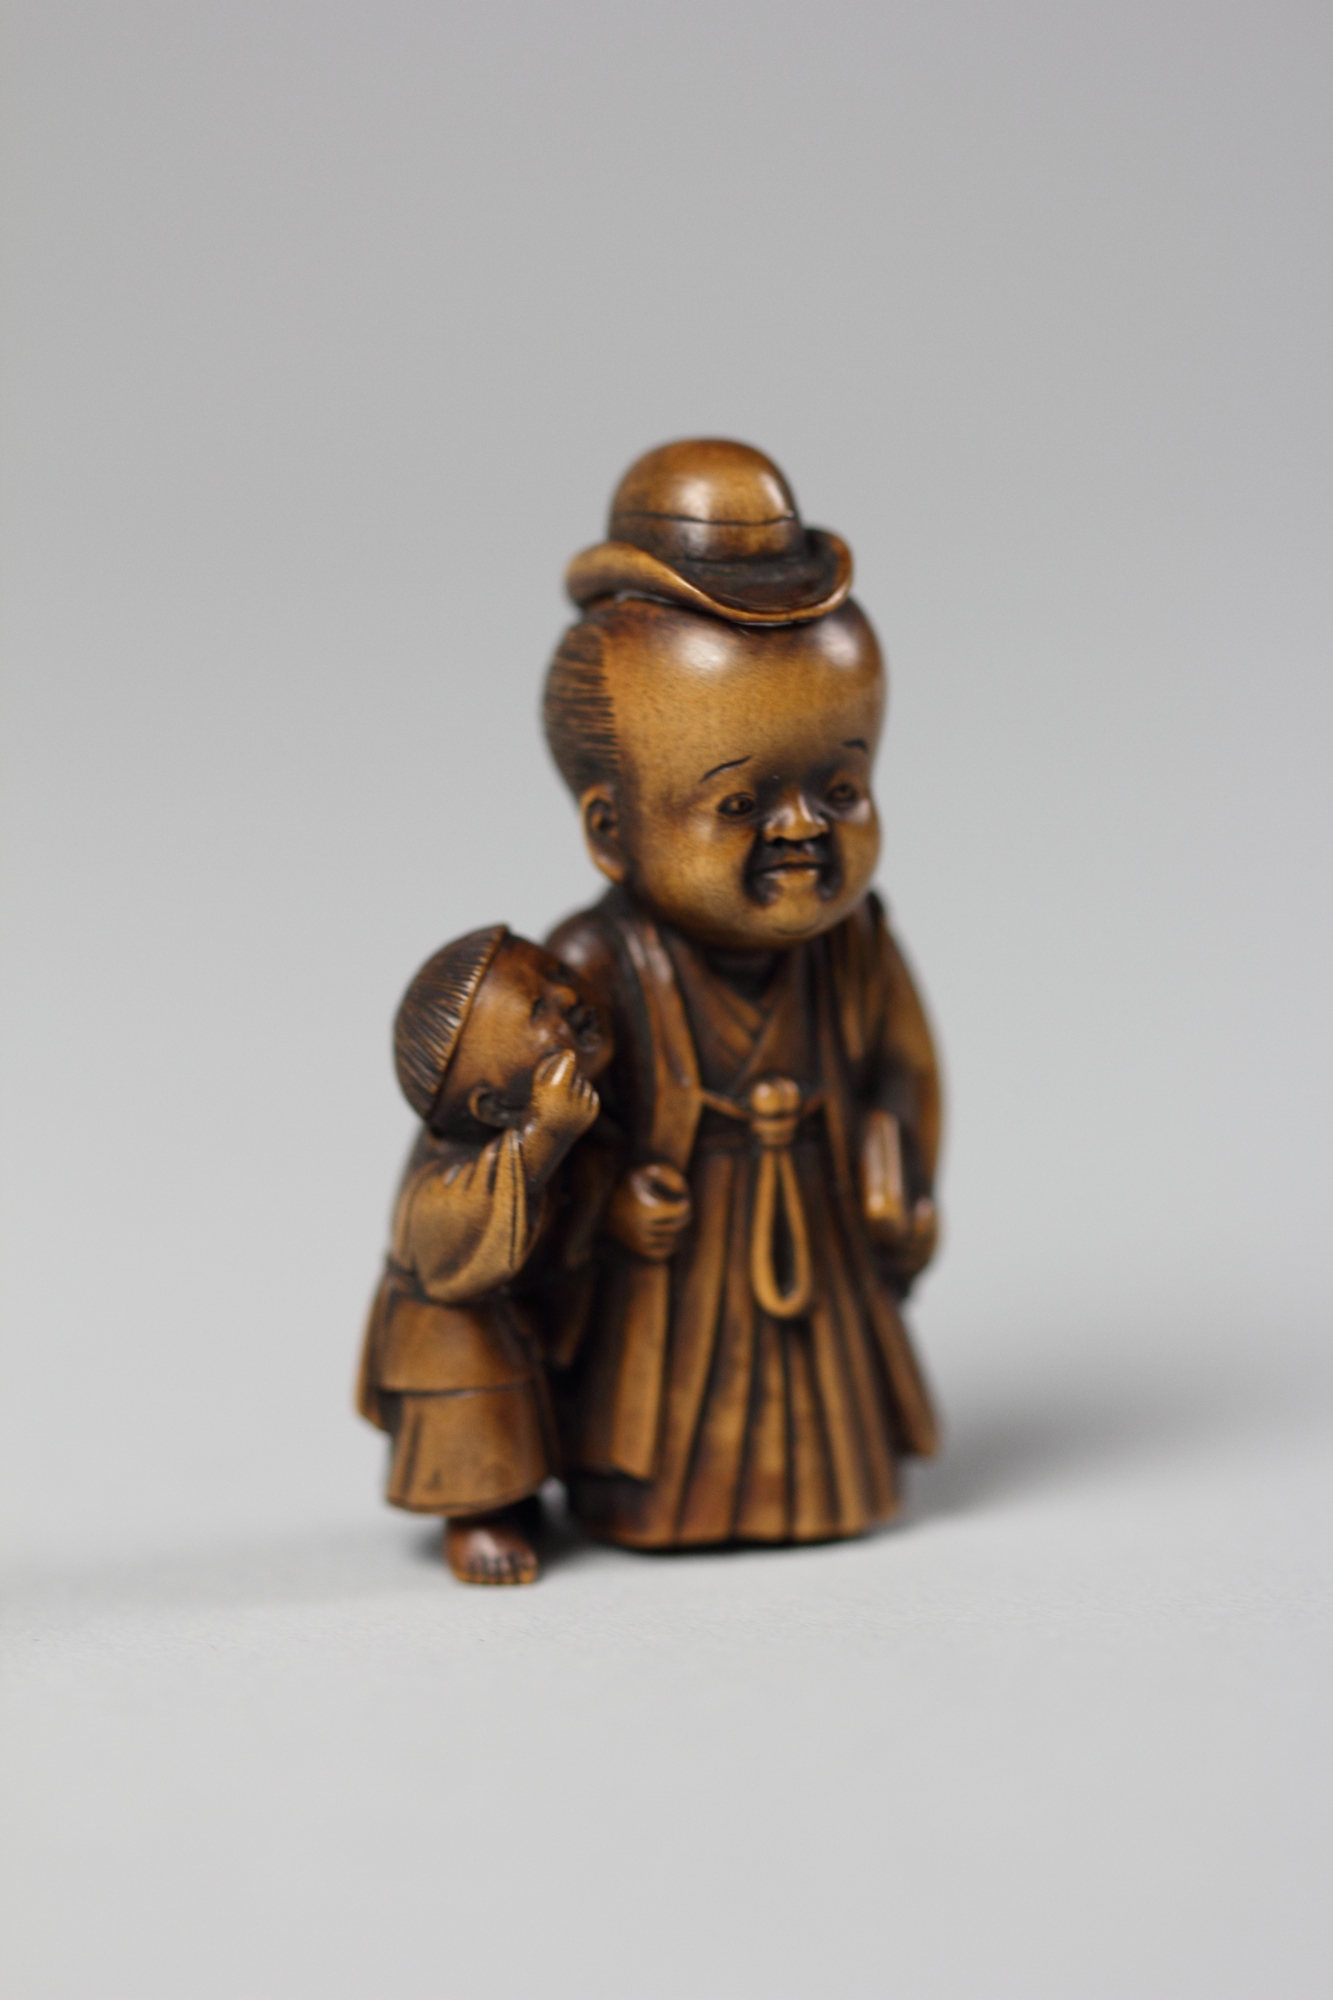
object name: netsuke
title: Netsuke of Two Figures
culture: japanese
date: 1801-1900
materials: wood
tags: men